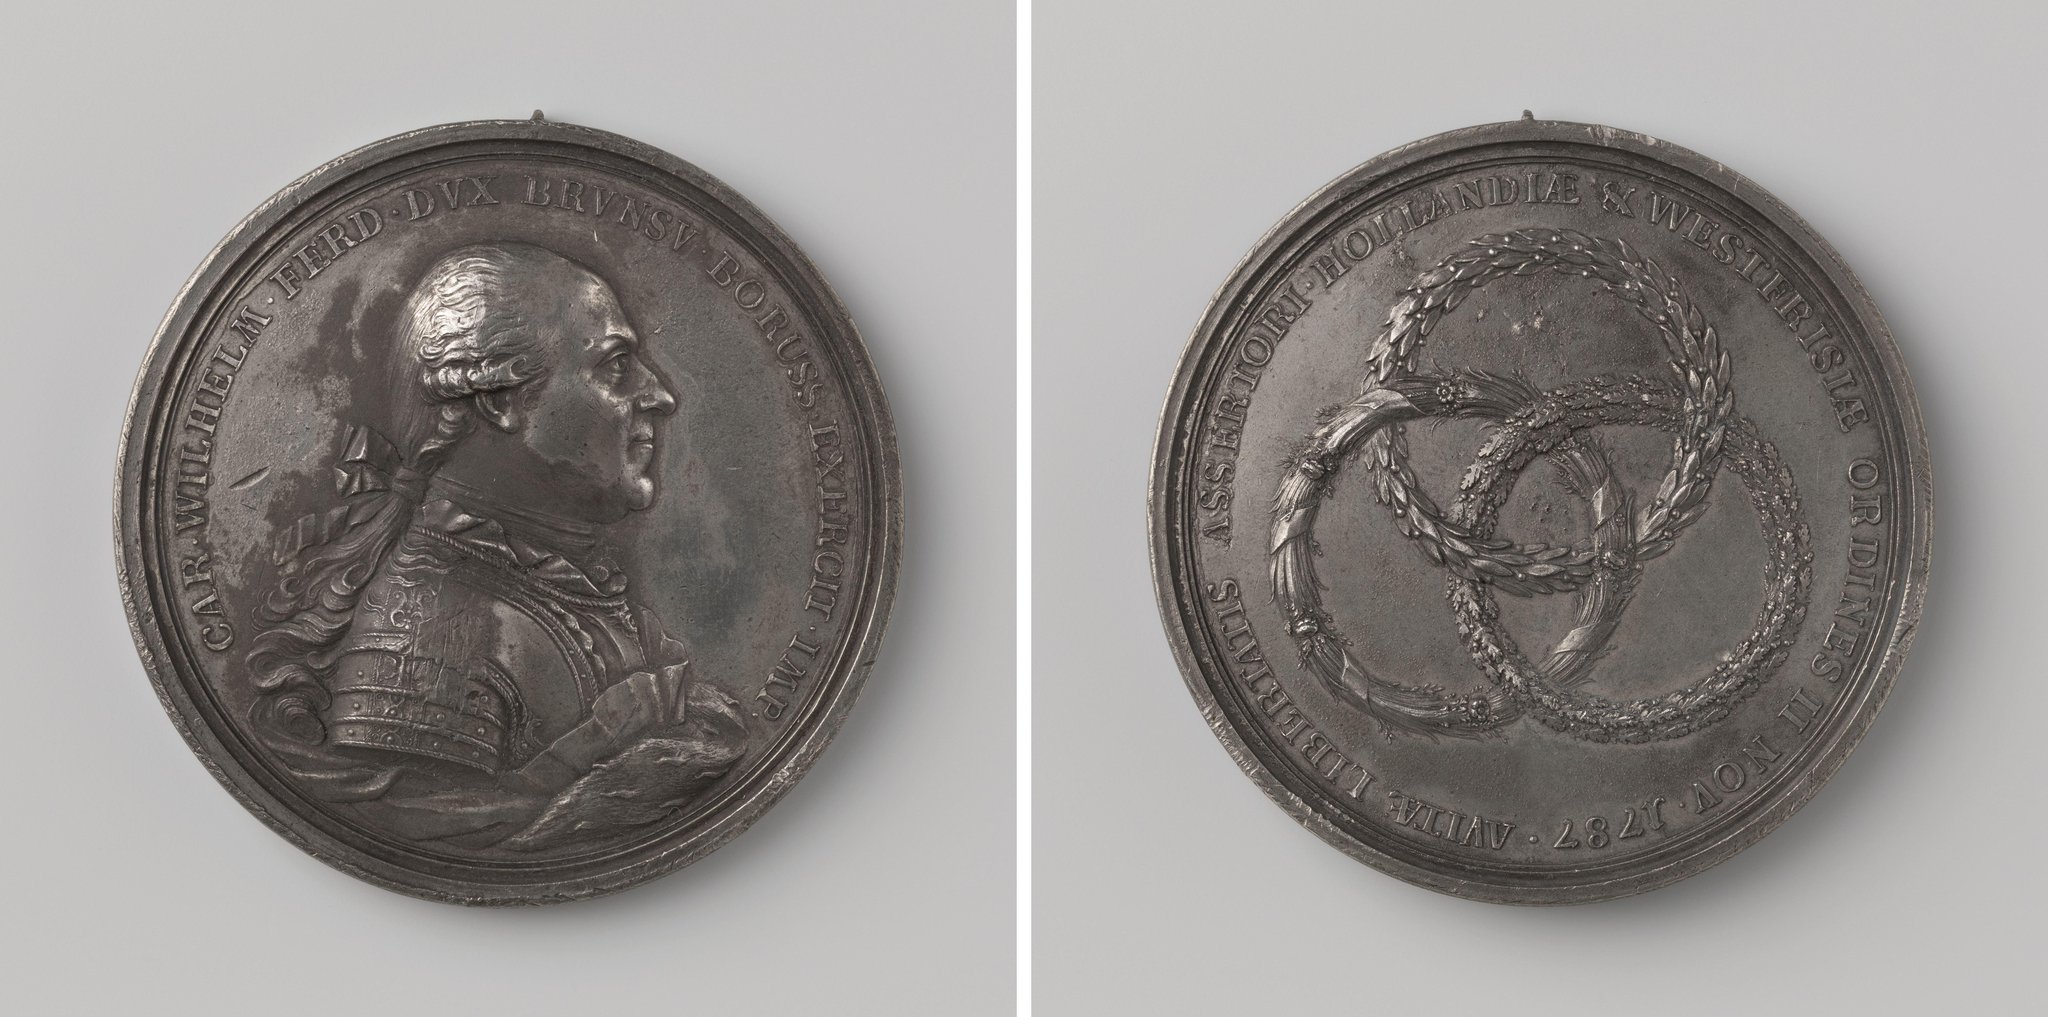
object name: history medal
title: Karel Willem Ferdinand, hertog van Brunswijk, penning aangeboden door de Staten van Holland en West-Friesland wegens het herstel van de orde in de Nederlanden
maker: johann heinrich schepp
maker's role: sculptor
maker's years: 1736-1811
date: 1787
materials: lead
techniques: striking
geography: the hague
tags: karel willem ferdinand hertog van brunswijk-wolfenbüttel, holland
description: Loden penning. Voorzijde: borststuk man binnen omschrift. Keerzijde: lauwerkrans, eikenkrans en krans van grashalmen met elkaar verstrengeld binnen omschrift